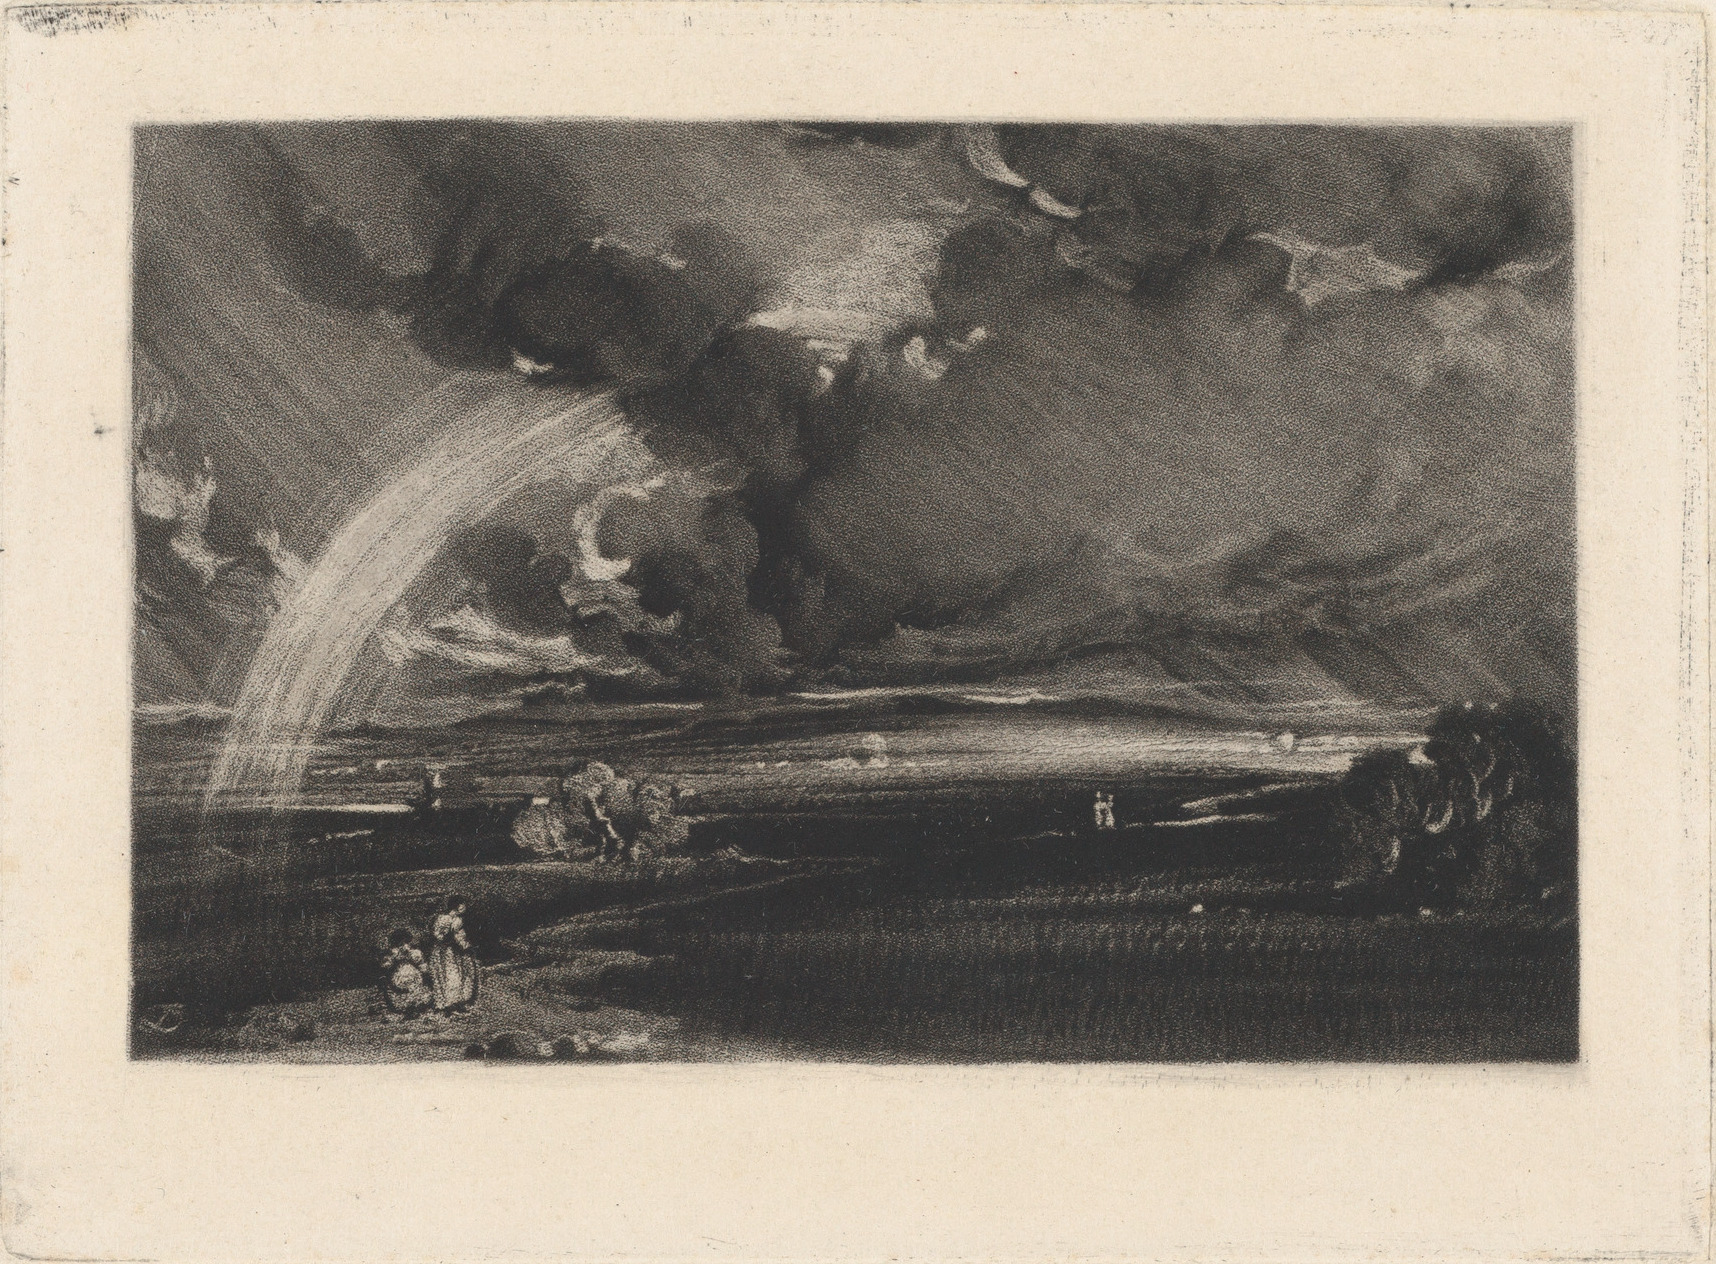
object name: print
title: Departing Storm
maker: david lucas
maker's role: artist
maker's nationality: british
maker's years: 1802-1881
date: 1829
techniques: mezzotint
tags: landscapes,clouds